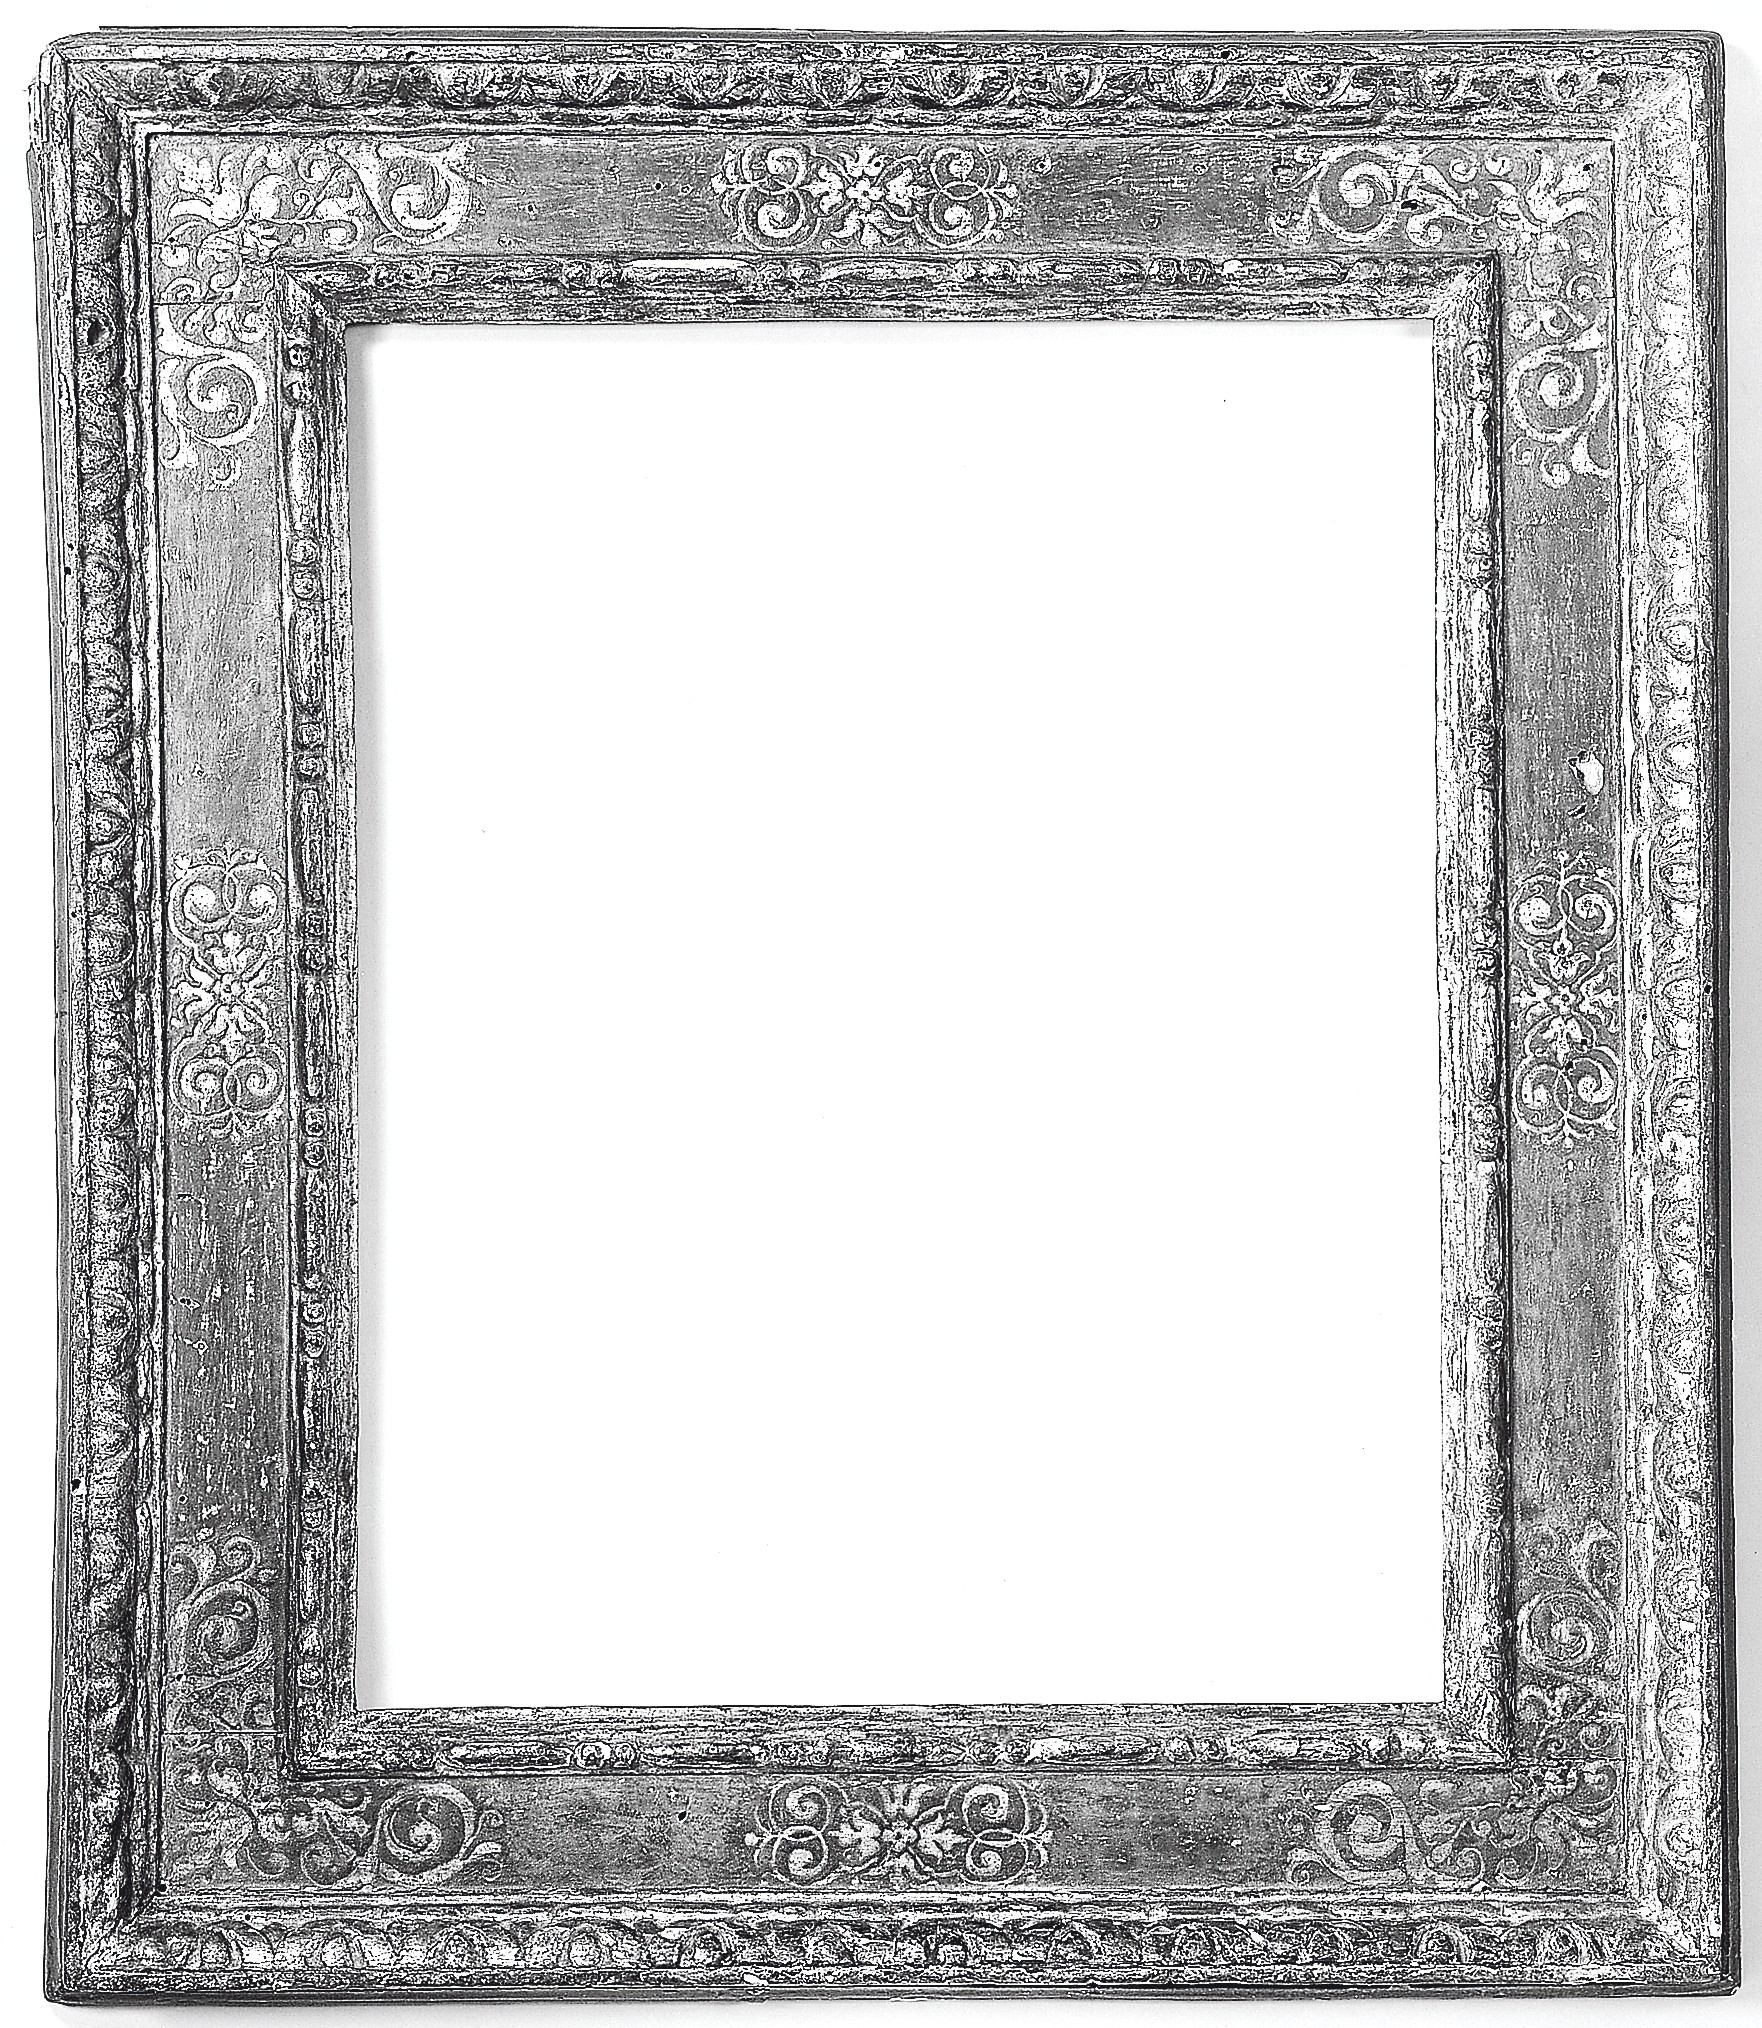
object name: frame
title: Cassetta frame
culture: italian, veneto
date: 1534-1566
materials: wood